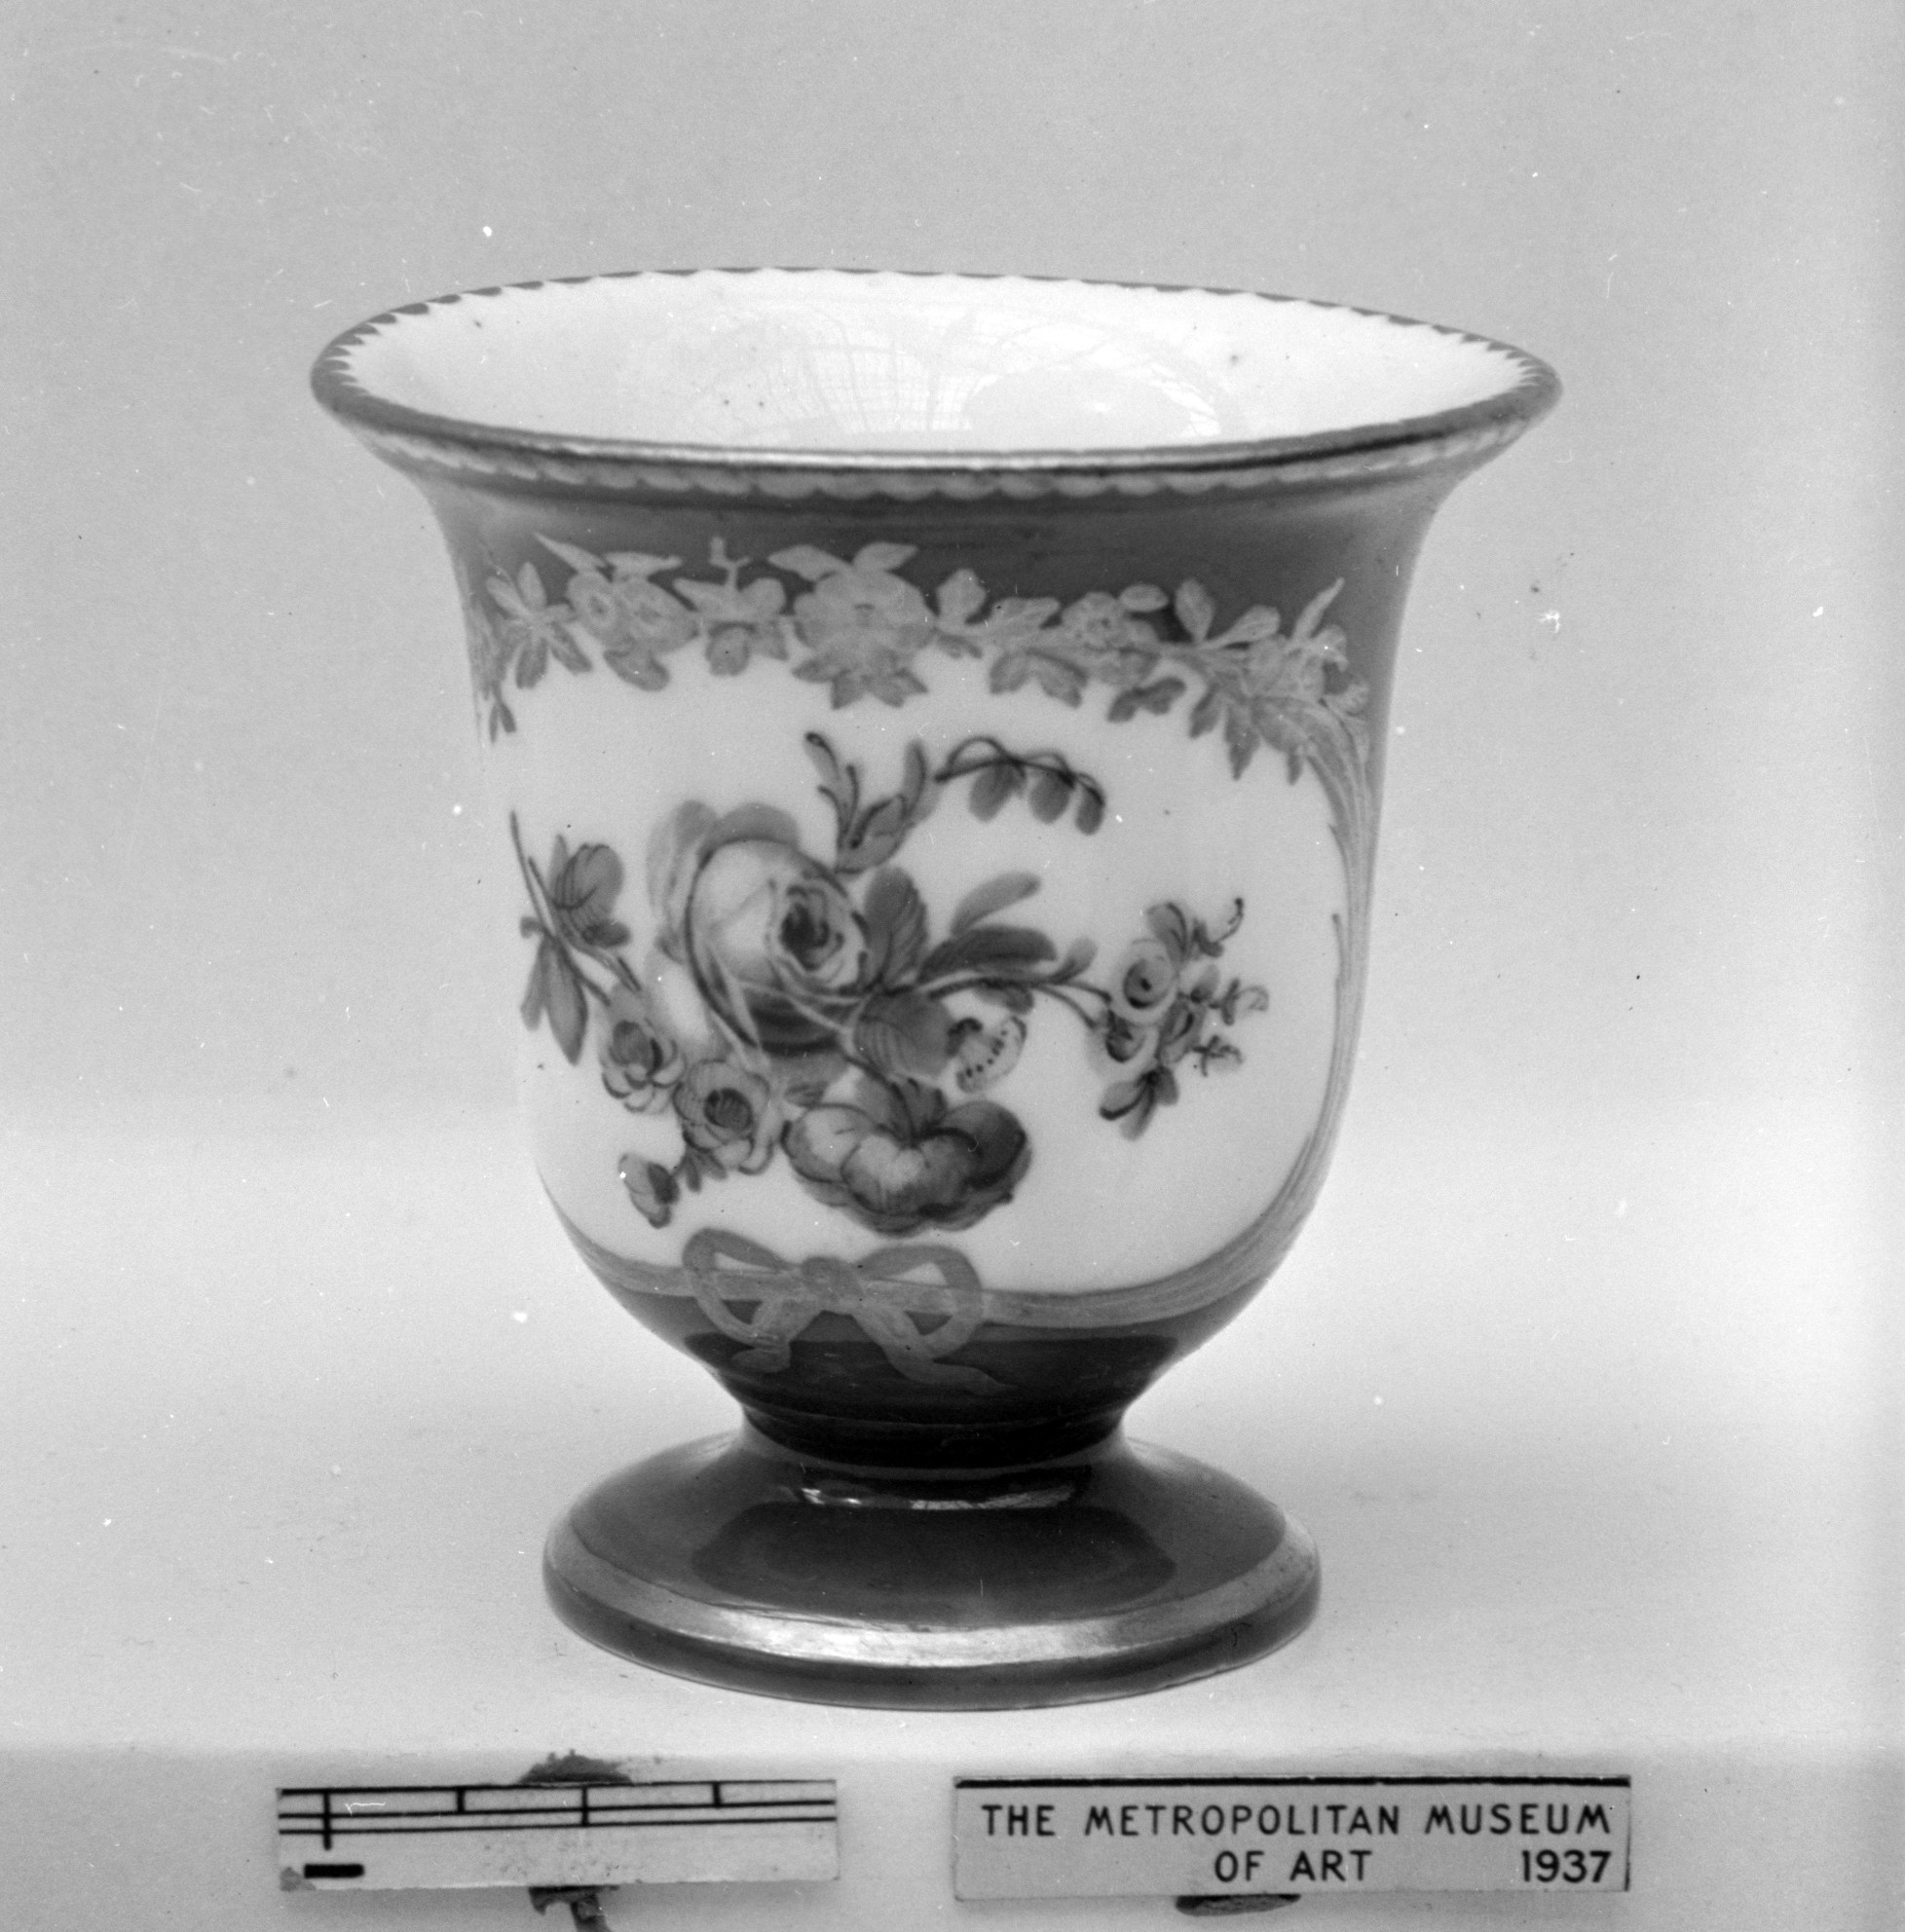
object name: ice cream cup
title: Ice cream cup (Tasse à glace) (part of a service)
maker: sèvres manufactory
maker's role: manufactory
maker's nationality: french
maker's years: 1740-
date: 1780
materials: soft paste porcelain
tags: flowers